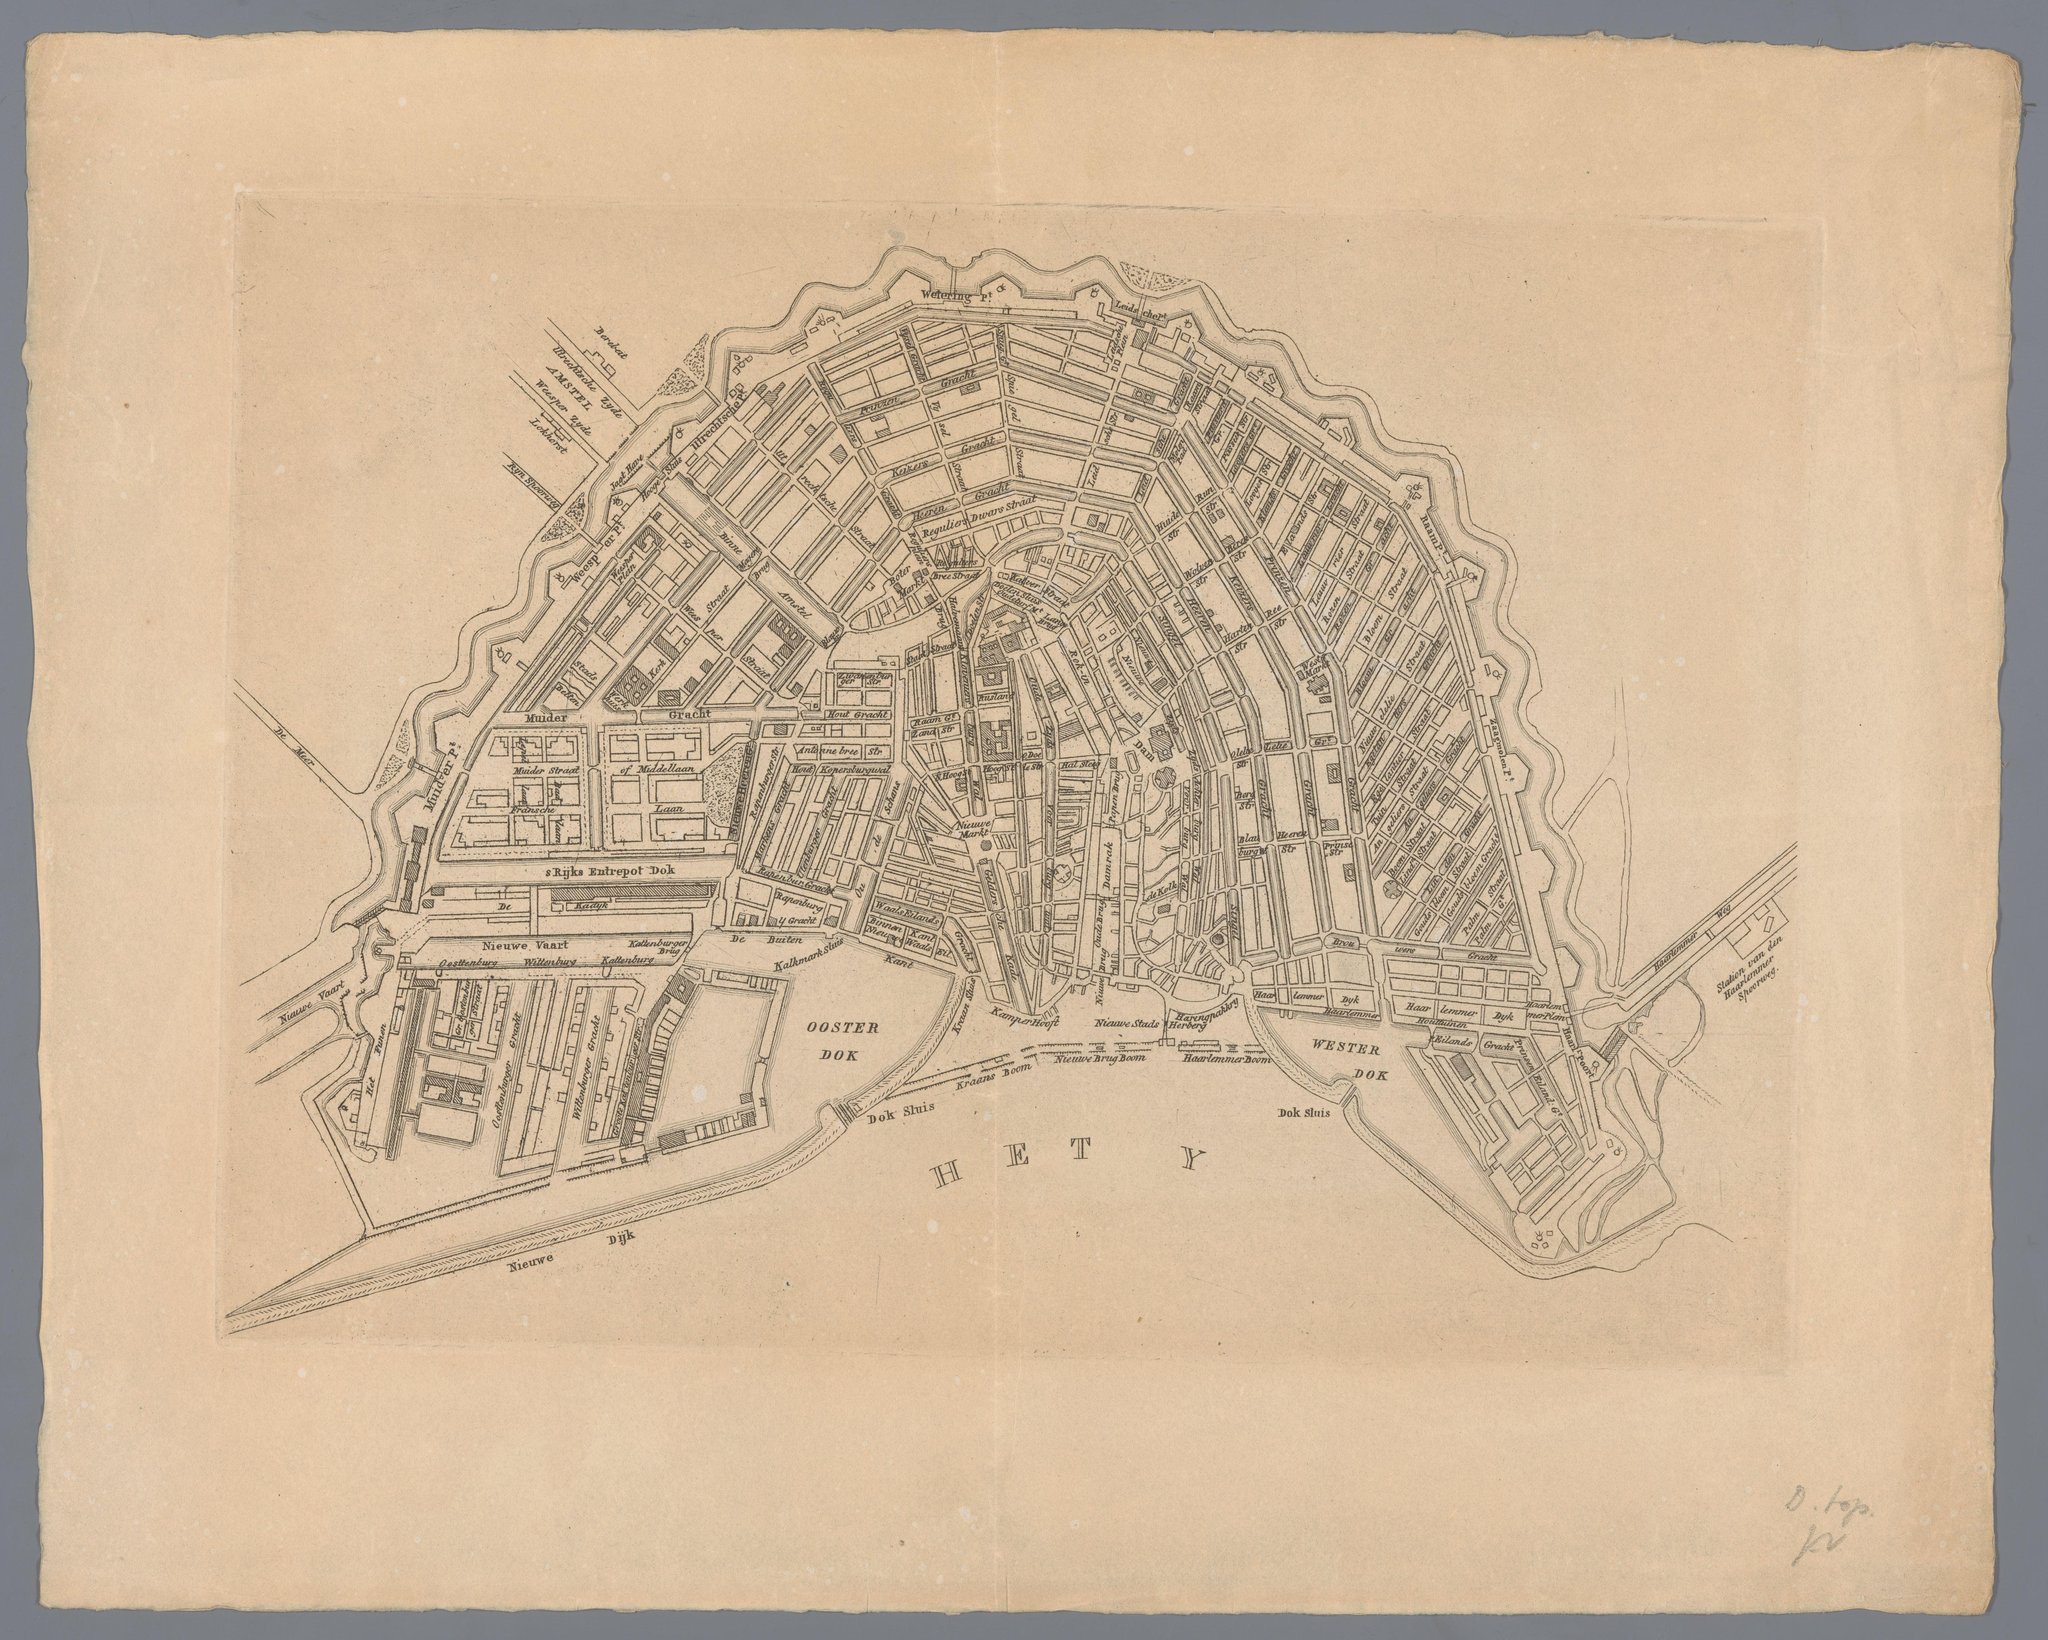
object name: print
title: Plattegrond van Amsterdam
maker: Anonymous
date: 1845-1878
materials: paper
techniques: etching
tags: maps of cities, amsterdam